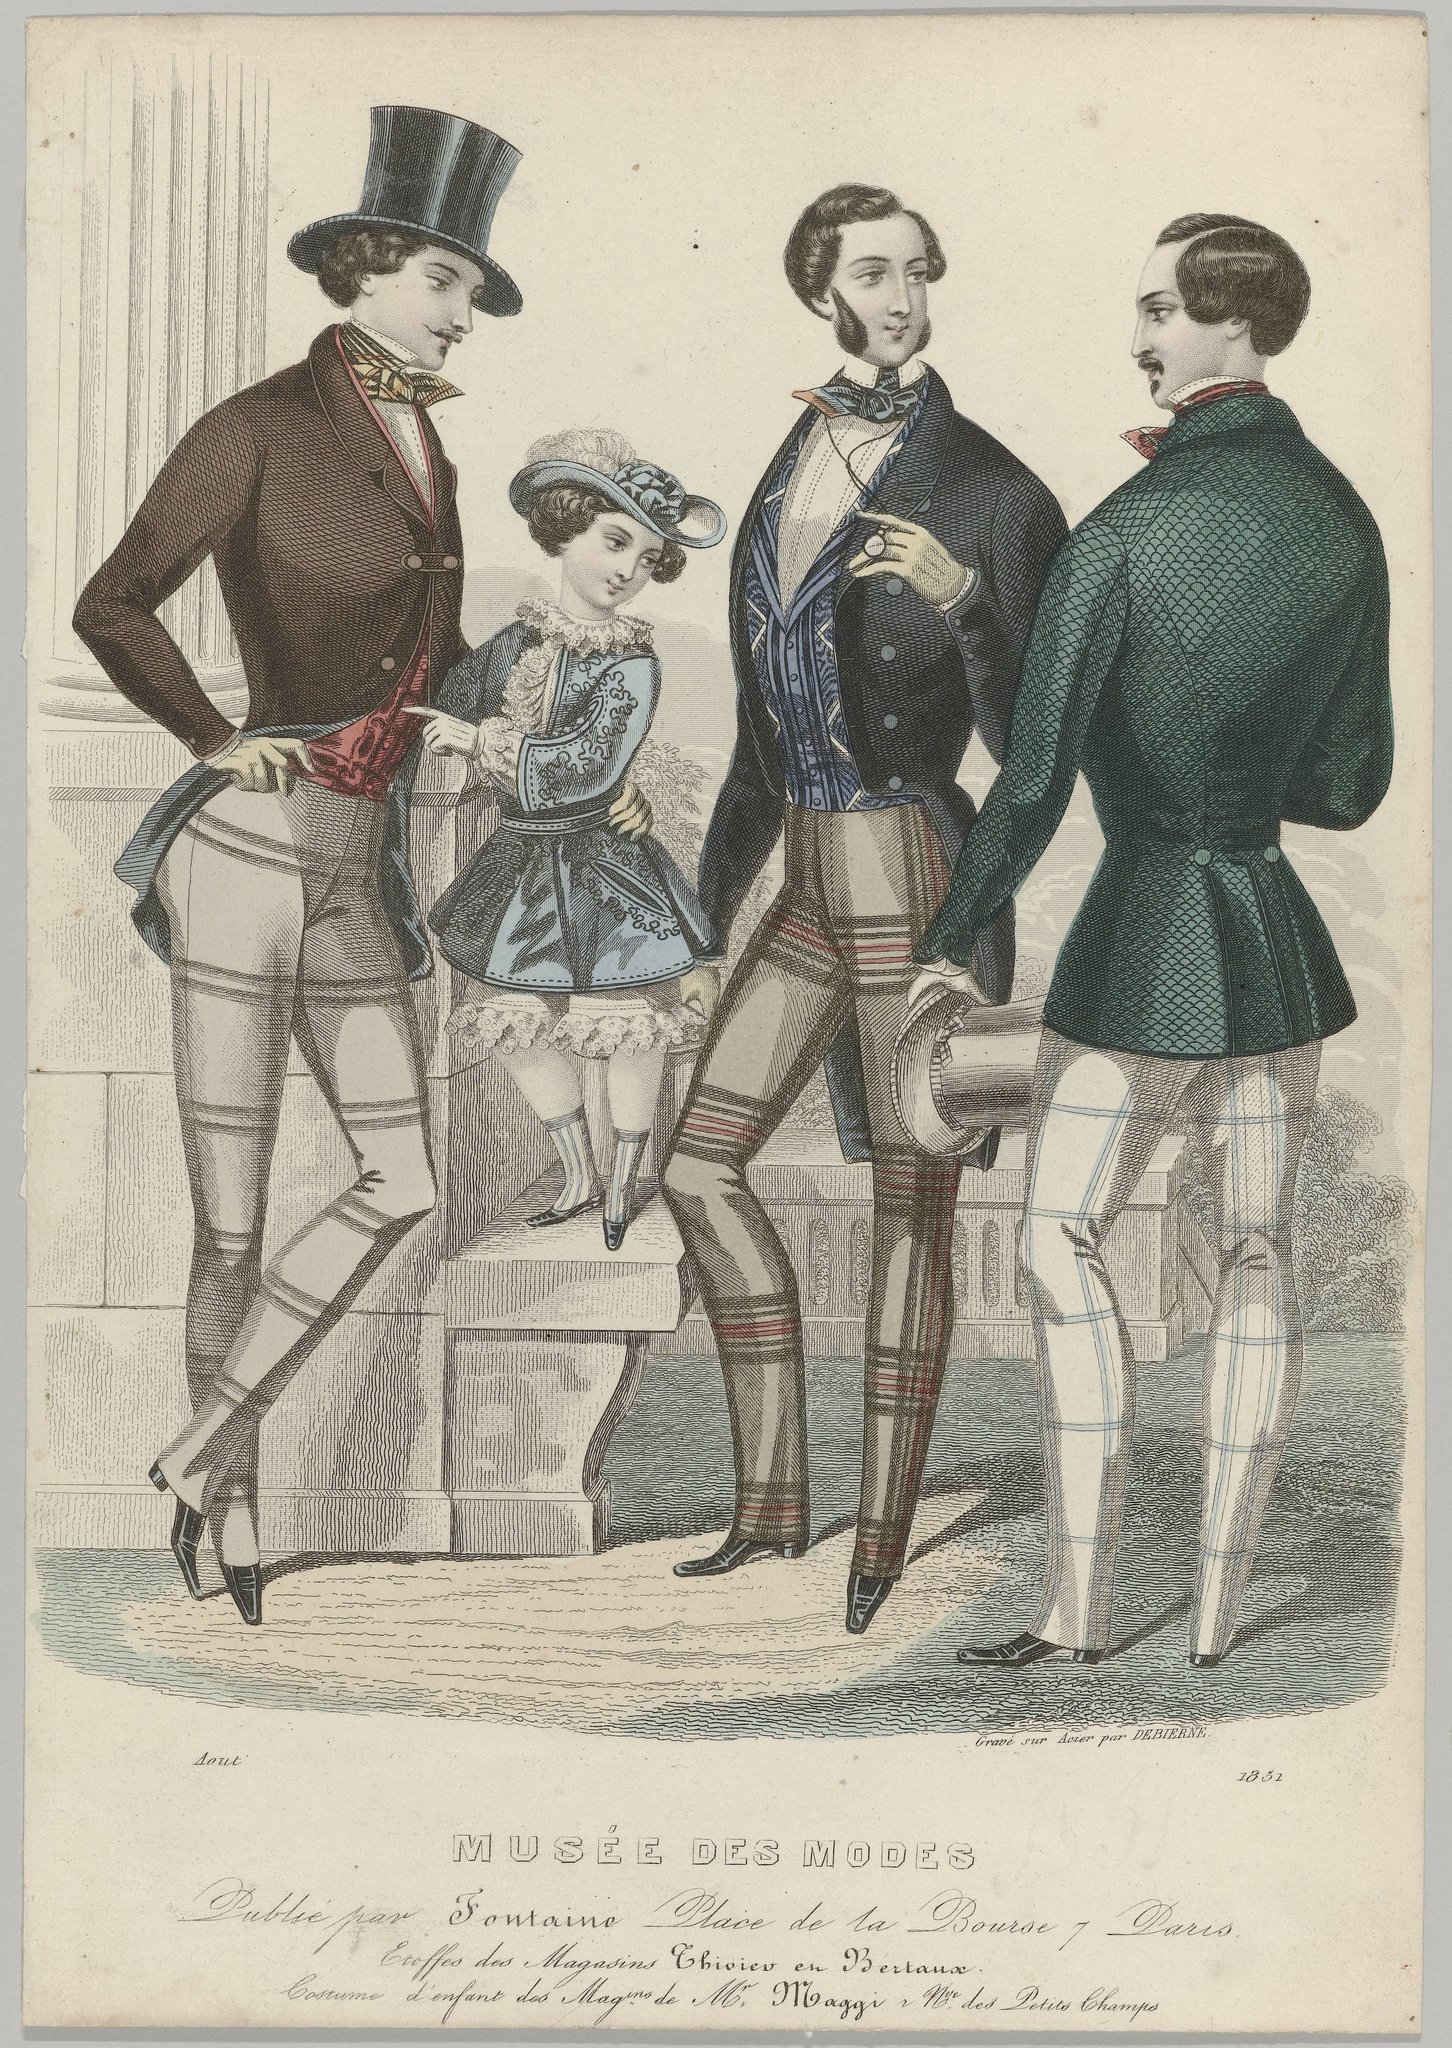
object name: fashion print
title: Musée des Modes, août 1851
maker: debierne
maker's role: print maker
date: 1851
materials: paper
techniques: hand coloring, engraving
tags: clothing for the upper part of the body (vest) (+ men's clothes), clothes, costume (+ children's clothes), head-gear: hat (+ children's clothes), monocle, single lorgnette, neck-gear ~ clothing (+ men's clothes), trousers, breeches, etc. (pantalon) (+ men's clothes), coat (+ men's clothes), fashion plates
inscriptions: caption: ‘Etoffes des Magasins Thirier en Bertaux. Costume d'enfant des Mag"ins de M"r Maggi r N.ve des Petits Champs’, title: ‘Musée des Modes’, address: ‘Publié par Fontaine Place de la Bourse 7 Paris.’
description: Drie mannen, van wie één op de rug gezien, en een kind op een stenen bank. De mannen dragen diverse jassen en vesten op geruite of gestreepte spanbroeken. Volgens het onderschrift zijn de stoffen van Thirier en Bertaux en komt de kinderkleding uit de winkels van Maggi. Prent uit het modetijdschrift Musée des Modes (1837-1890).